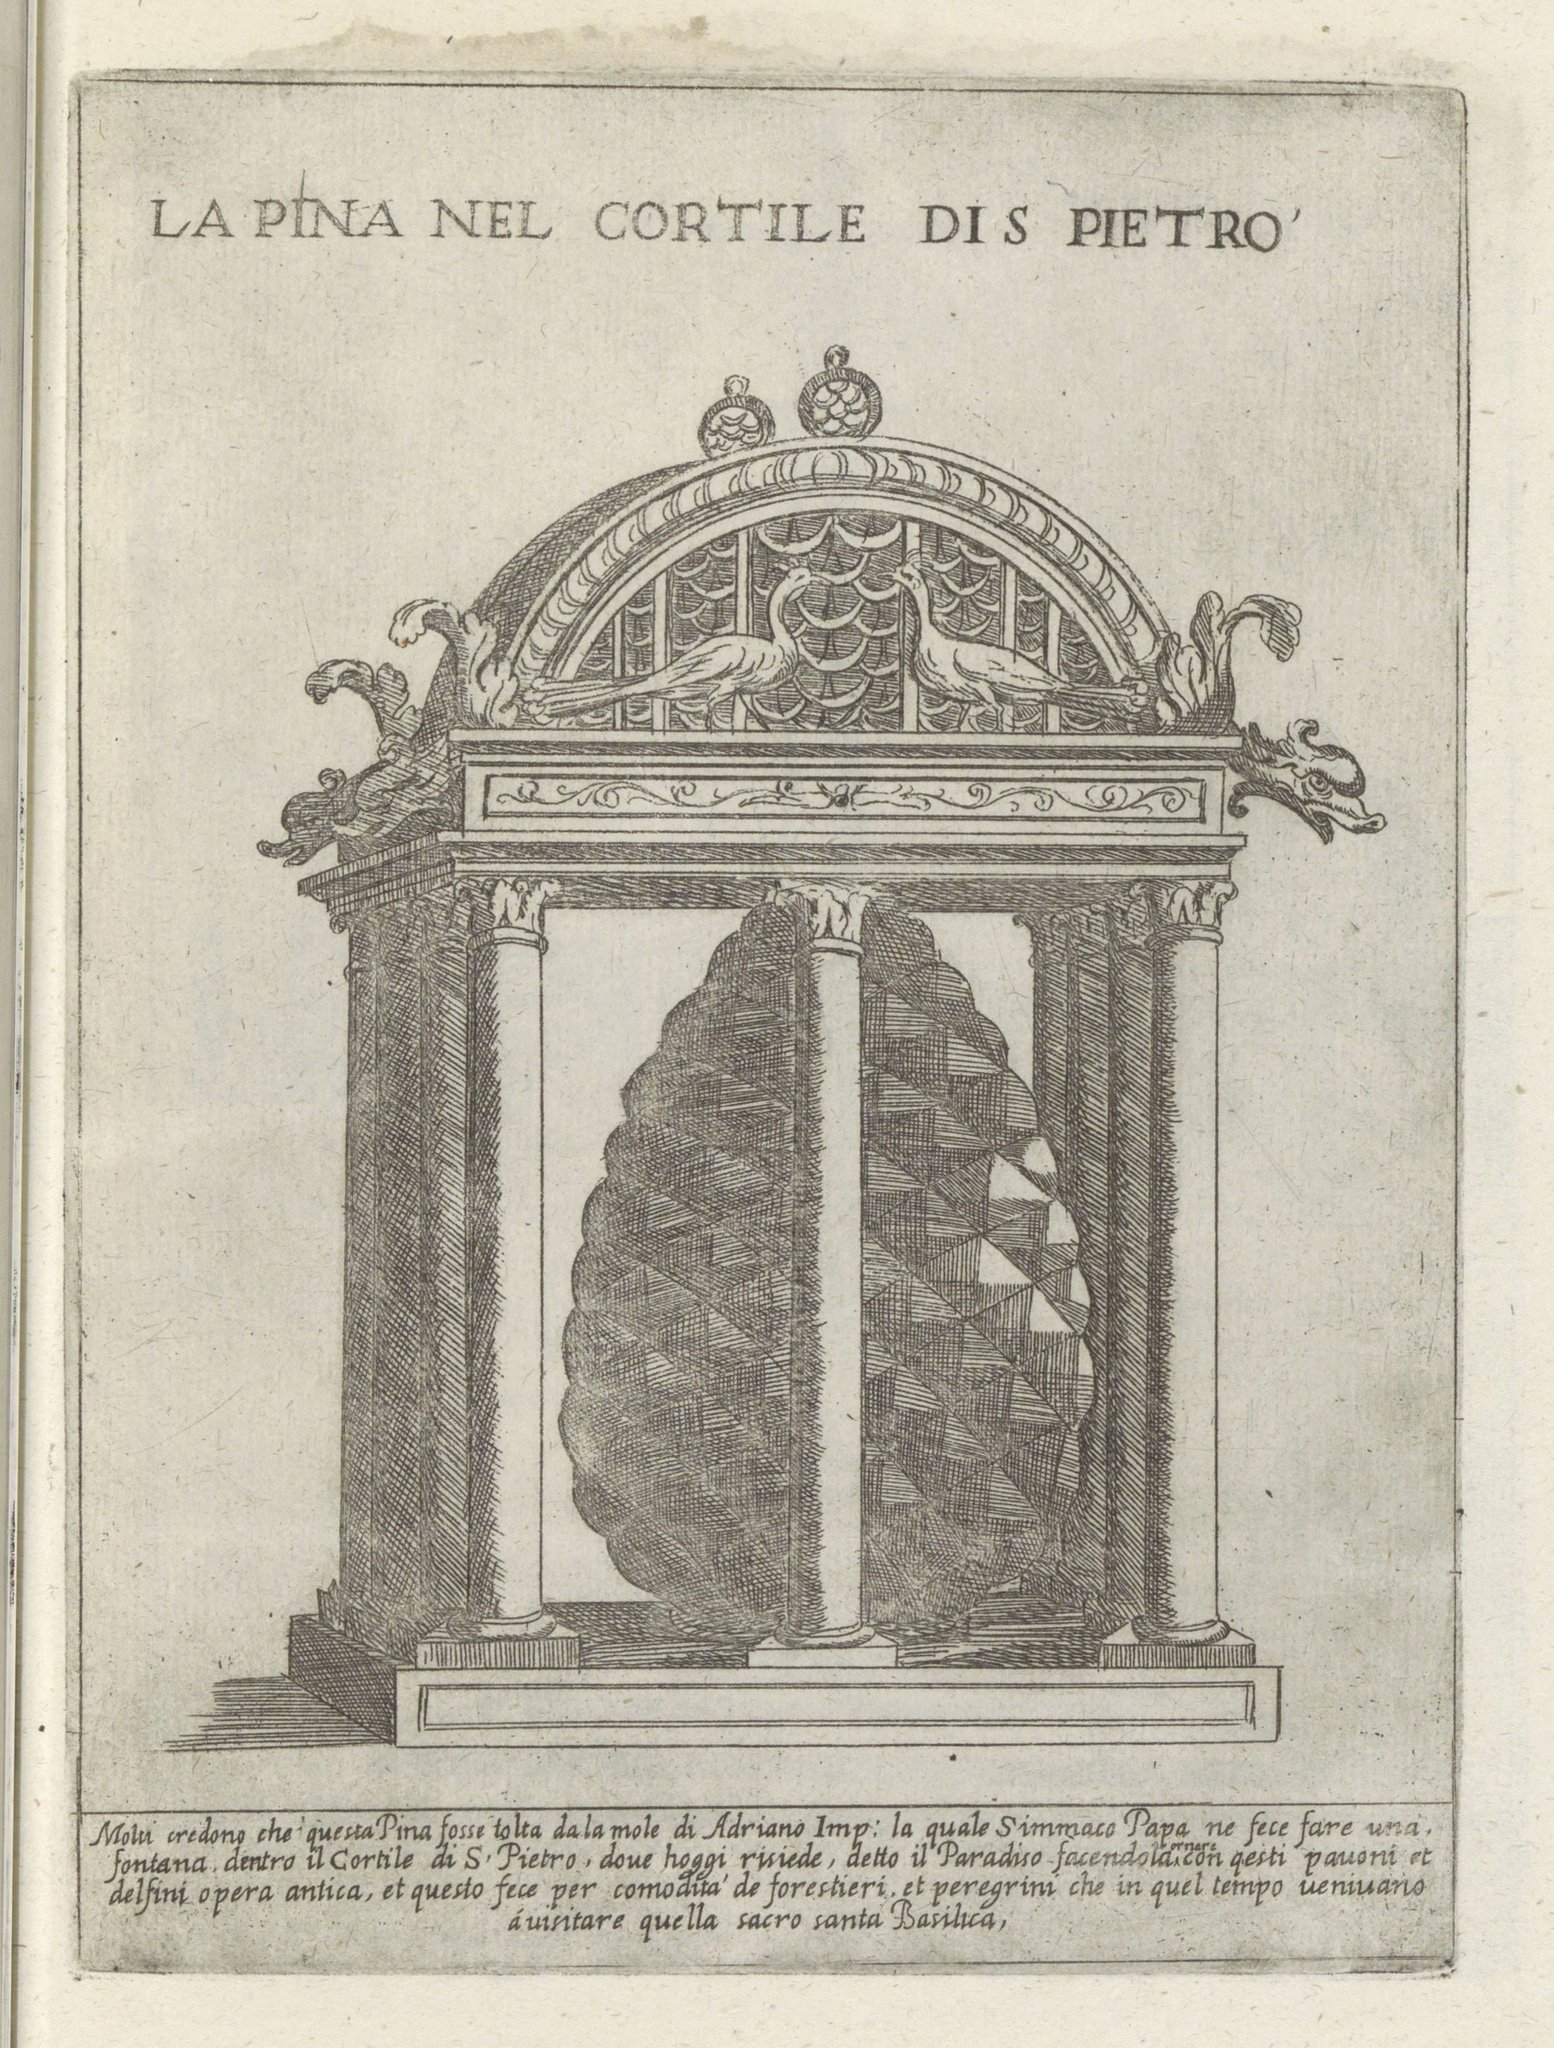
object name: print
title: La Pina nel Cortile di S. Pietro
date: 1576-1618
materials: paper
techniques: etching, intaglio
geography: vatican city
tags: piece of sculpture, reproduction of a piece of sculpture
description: De brozen Pigna, die ooit deel uitmaakte van de Fontana della Pigna, maar vandaag de dag de Cortile della Pigna in Vaticaanstad siert. Tekst in het Italiaans in de ondermarge. De prent maakt deel uit van een album.